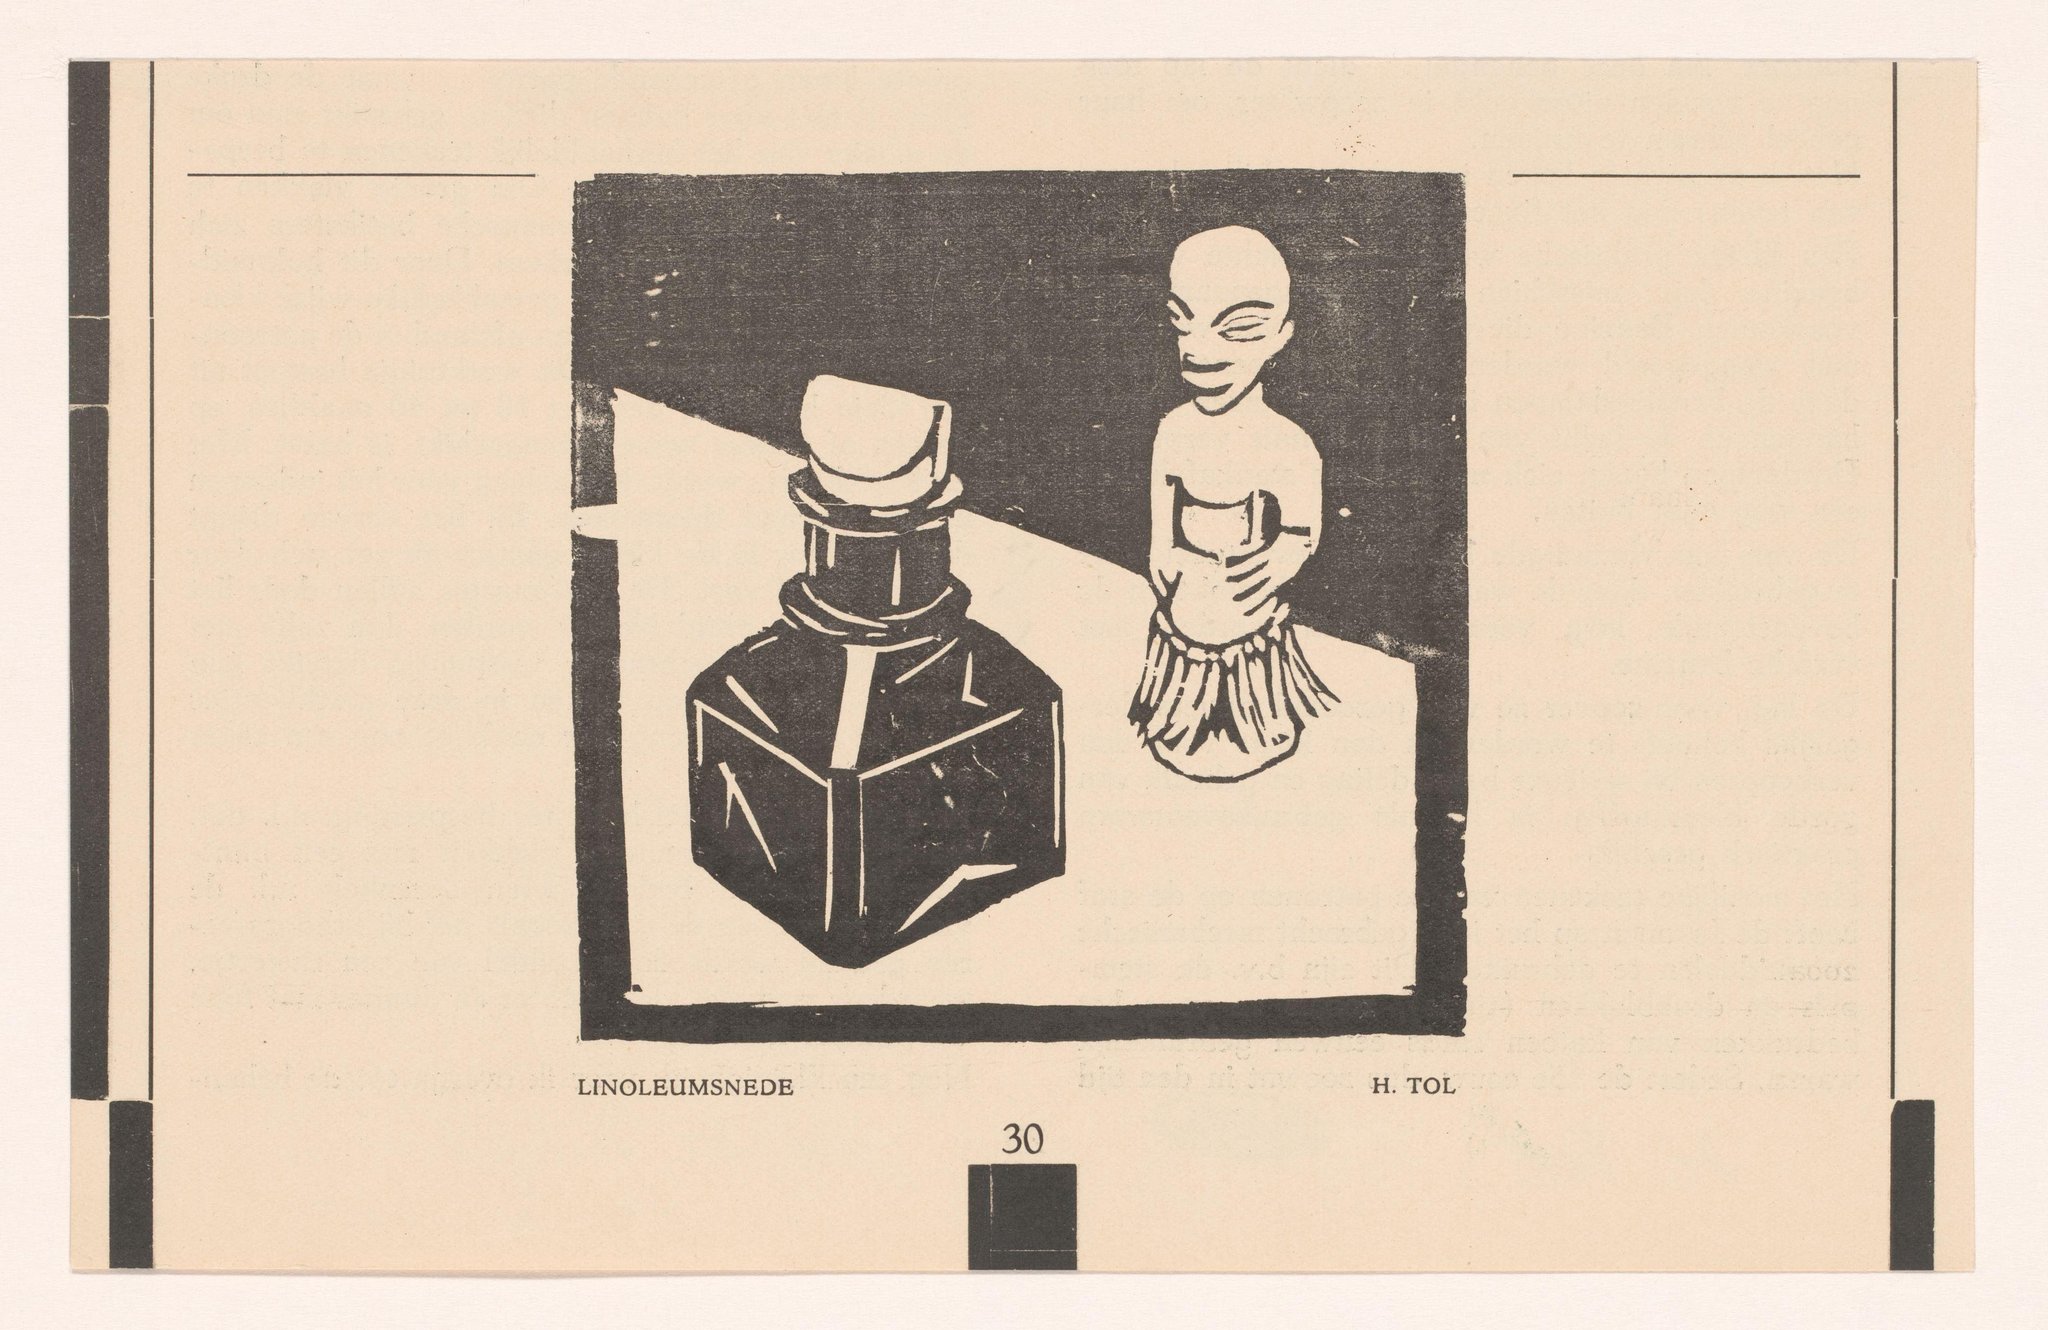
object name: print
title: Stilleven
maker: h. tol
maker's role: print maker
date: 1925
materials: paper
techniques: linocut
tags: still life of miscellaneous objects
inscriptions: collector's mark: Lugt 2228, collector's mark: Lugt 2760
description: Pagina 30 uit het eerste jaargang van het tijdschrift "De Fakkel", 1925.